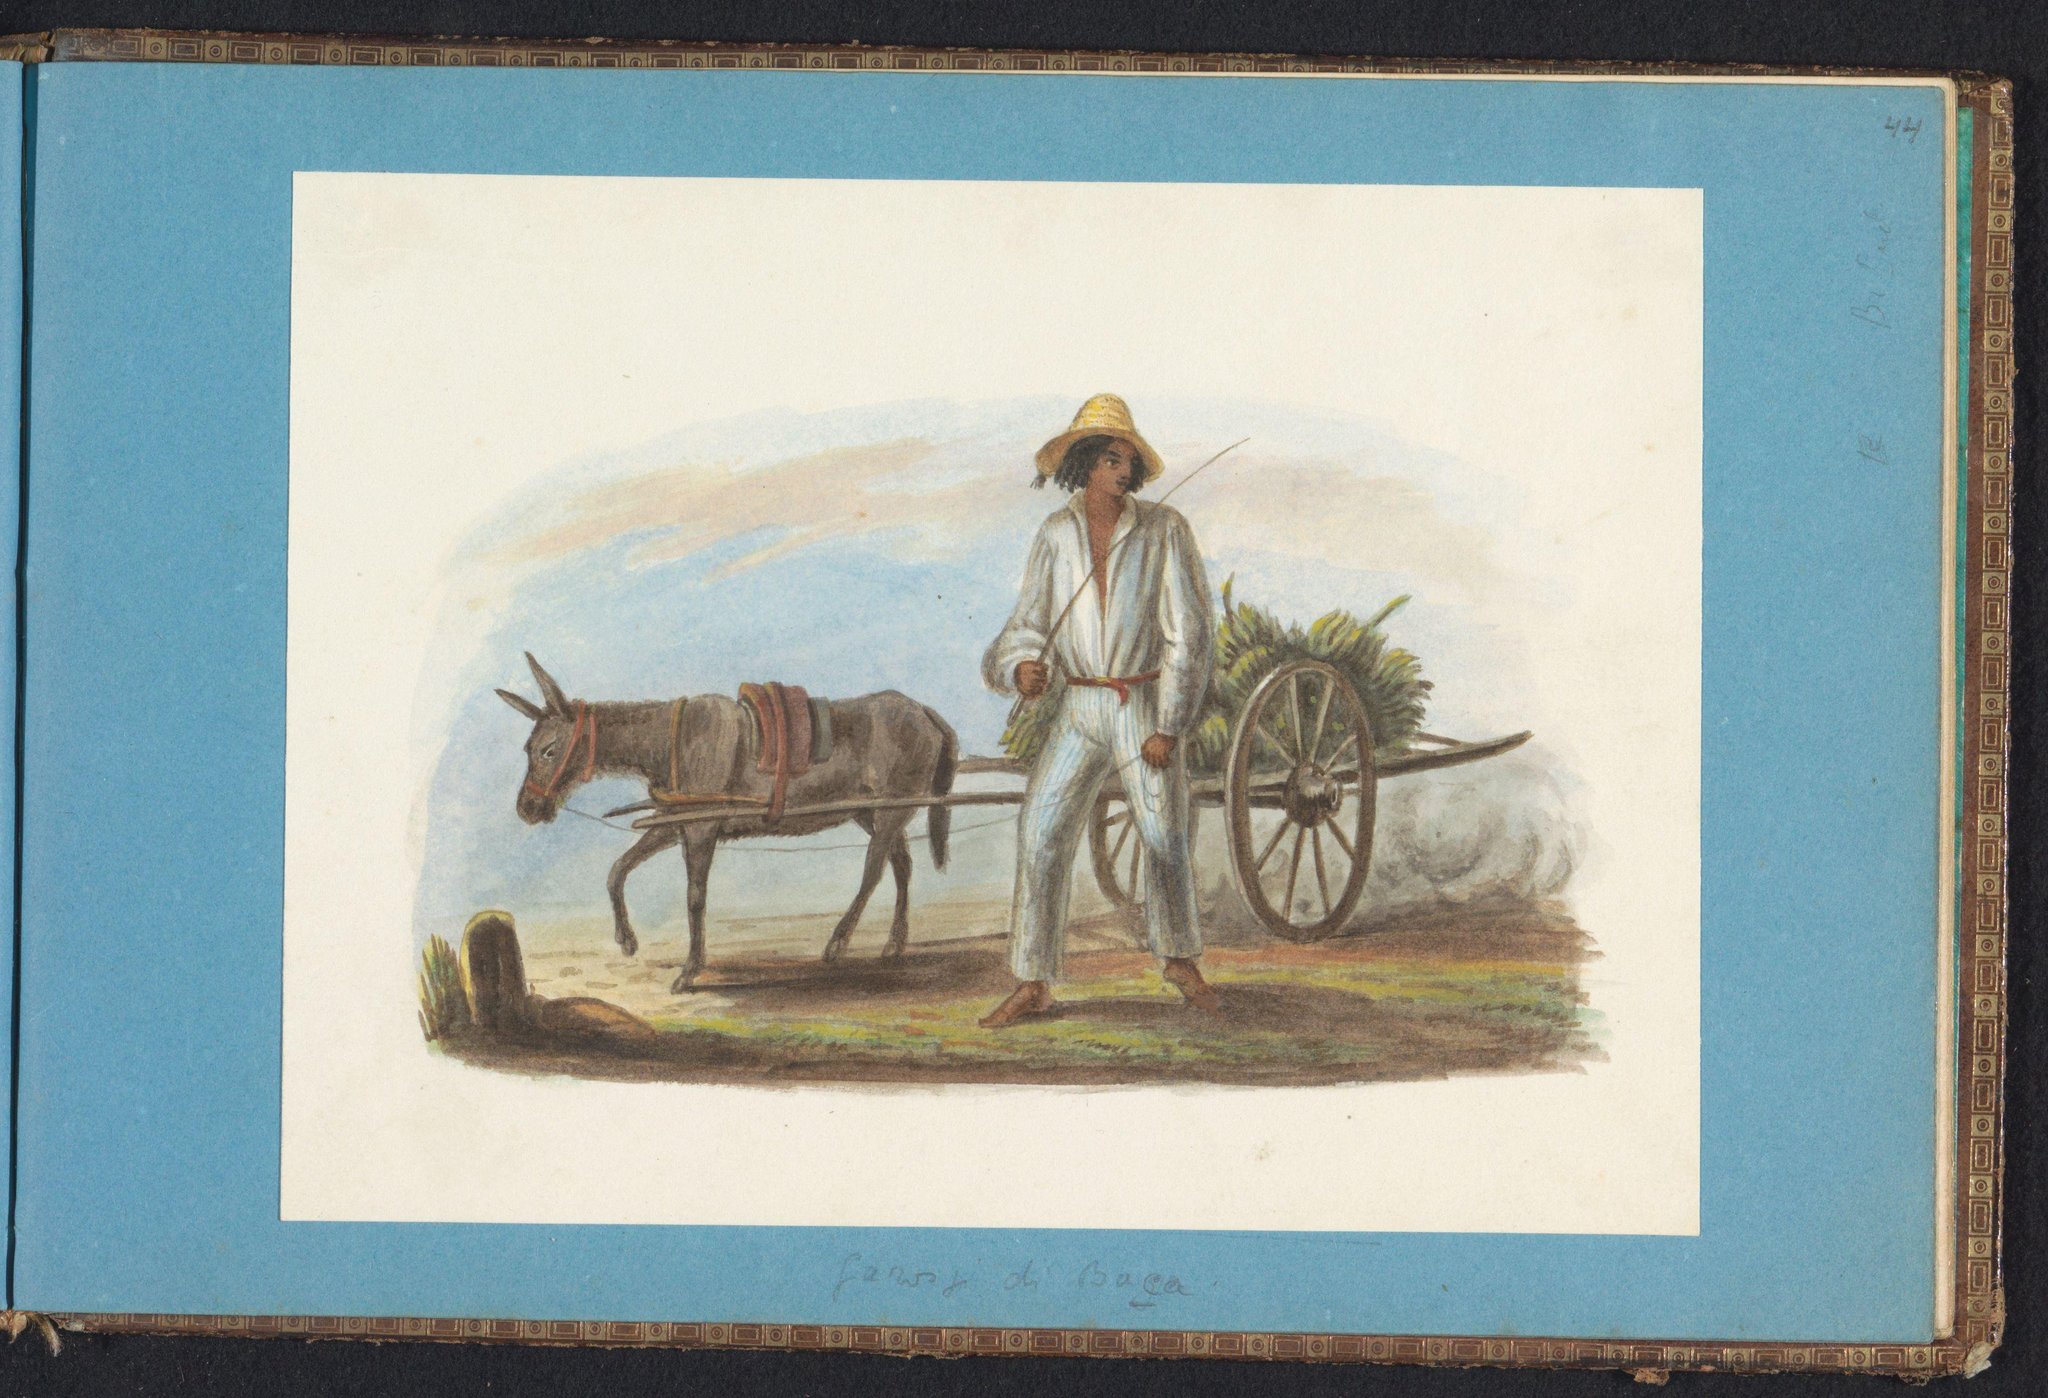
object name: watercolor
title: Man met kar met bananen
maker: jacob marius adriaan martini van geffen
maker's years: 1821-1866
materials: ink, paper, pencil, watercolor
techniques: brush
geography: suriname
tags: master ~ enslaved person, africans, slavery; serfs and enslaved persons, suriname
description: Een kar met bananen wordt voortgetrokken door een ezel. Een man, mogelijk tot slaaf gemaakt, houdt een zweep vast.